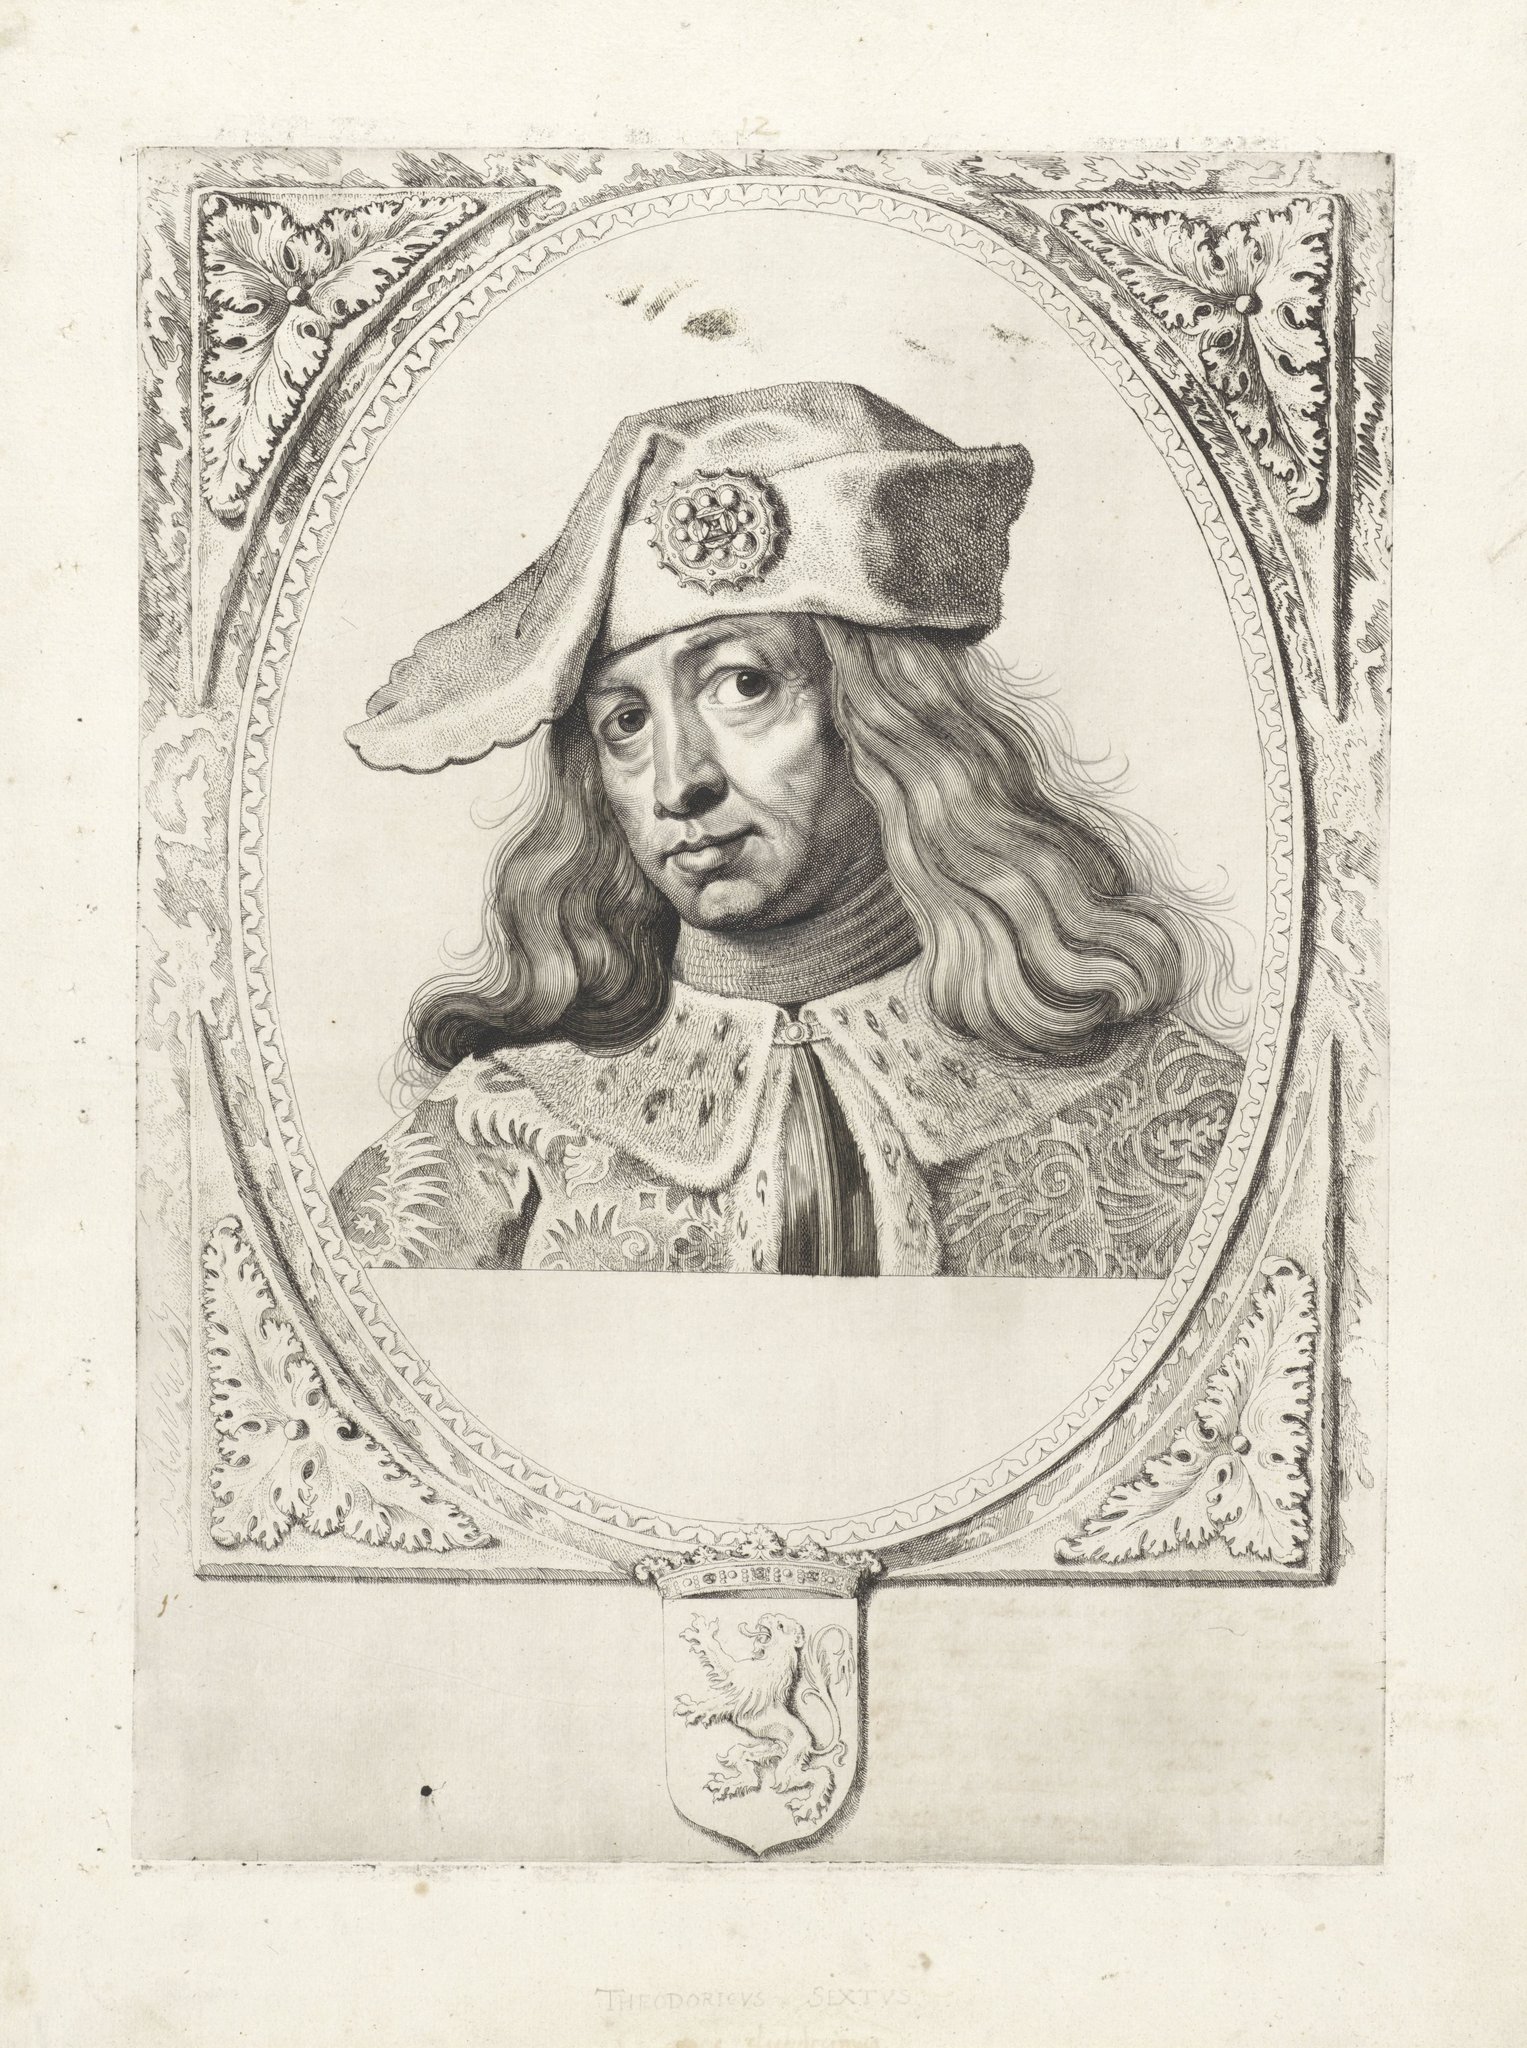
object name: print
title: Portret van Dirk VI, graaf van Holland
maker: cornelis visscher (ii)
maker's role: draughtsman, painter, print maker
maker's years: 1628-1658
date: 1650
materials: paper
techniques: engraving, etching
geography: haarlem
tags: head-gear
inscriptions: collector's mark: Lugt 240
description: Dirk VI, graaf van Holland, met een met parels en edelstenen verfraaide hoofddeksel. De omlijsting is versierd met het wapen van Holland.